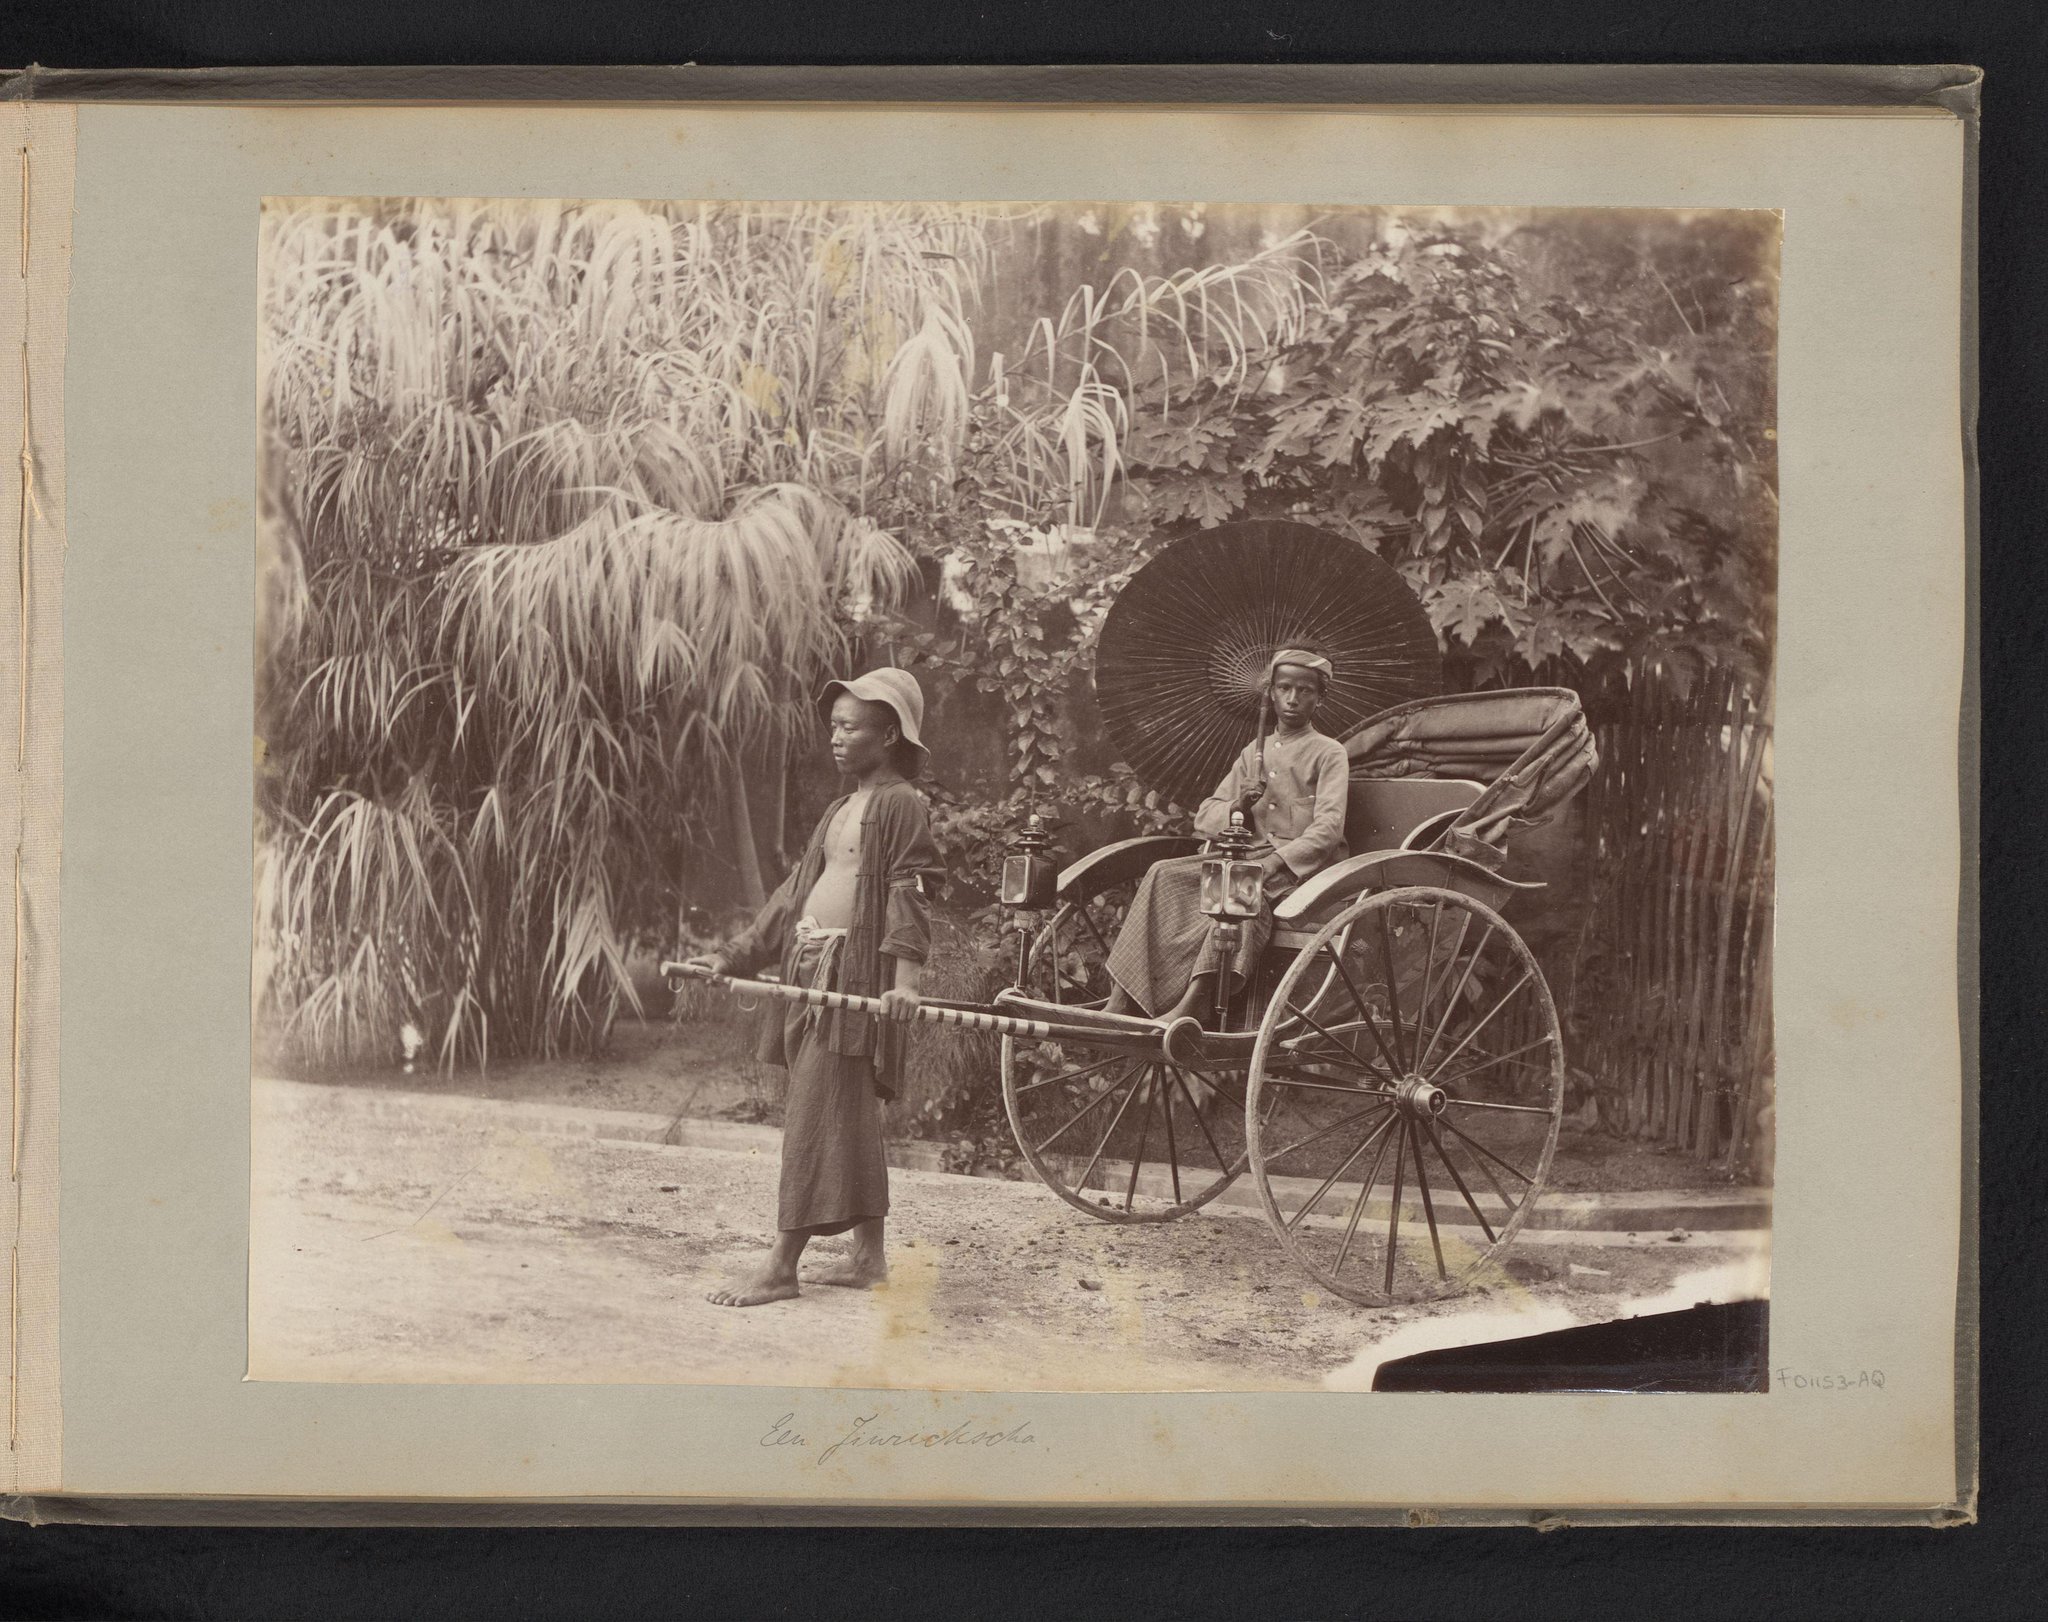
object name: photograph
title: Een Jiurickscha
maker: Anonymous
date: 1890-1895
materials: photographic support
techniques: albumen print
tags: rickshaw, historical persons, sumatra